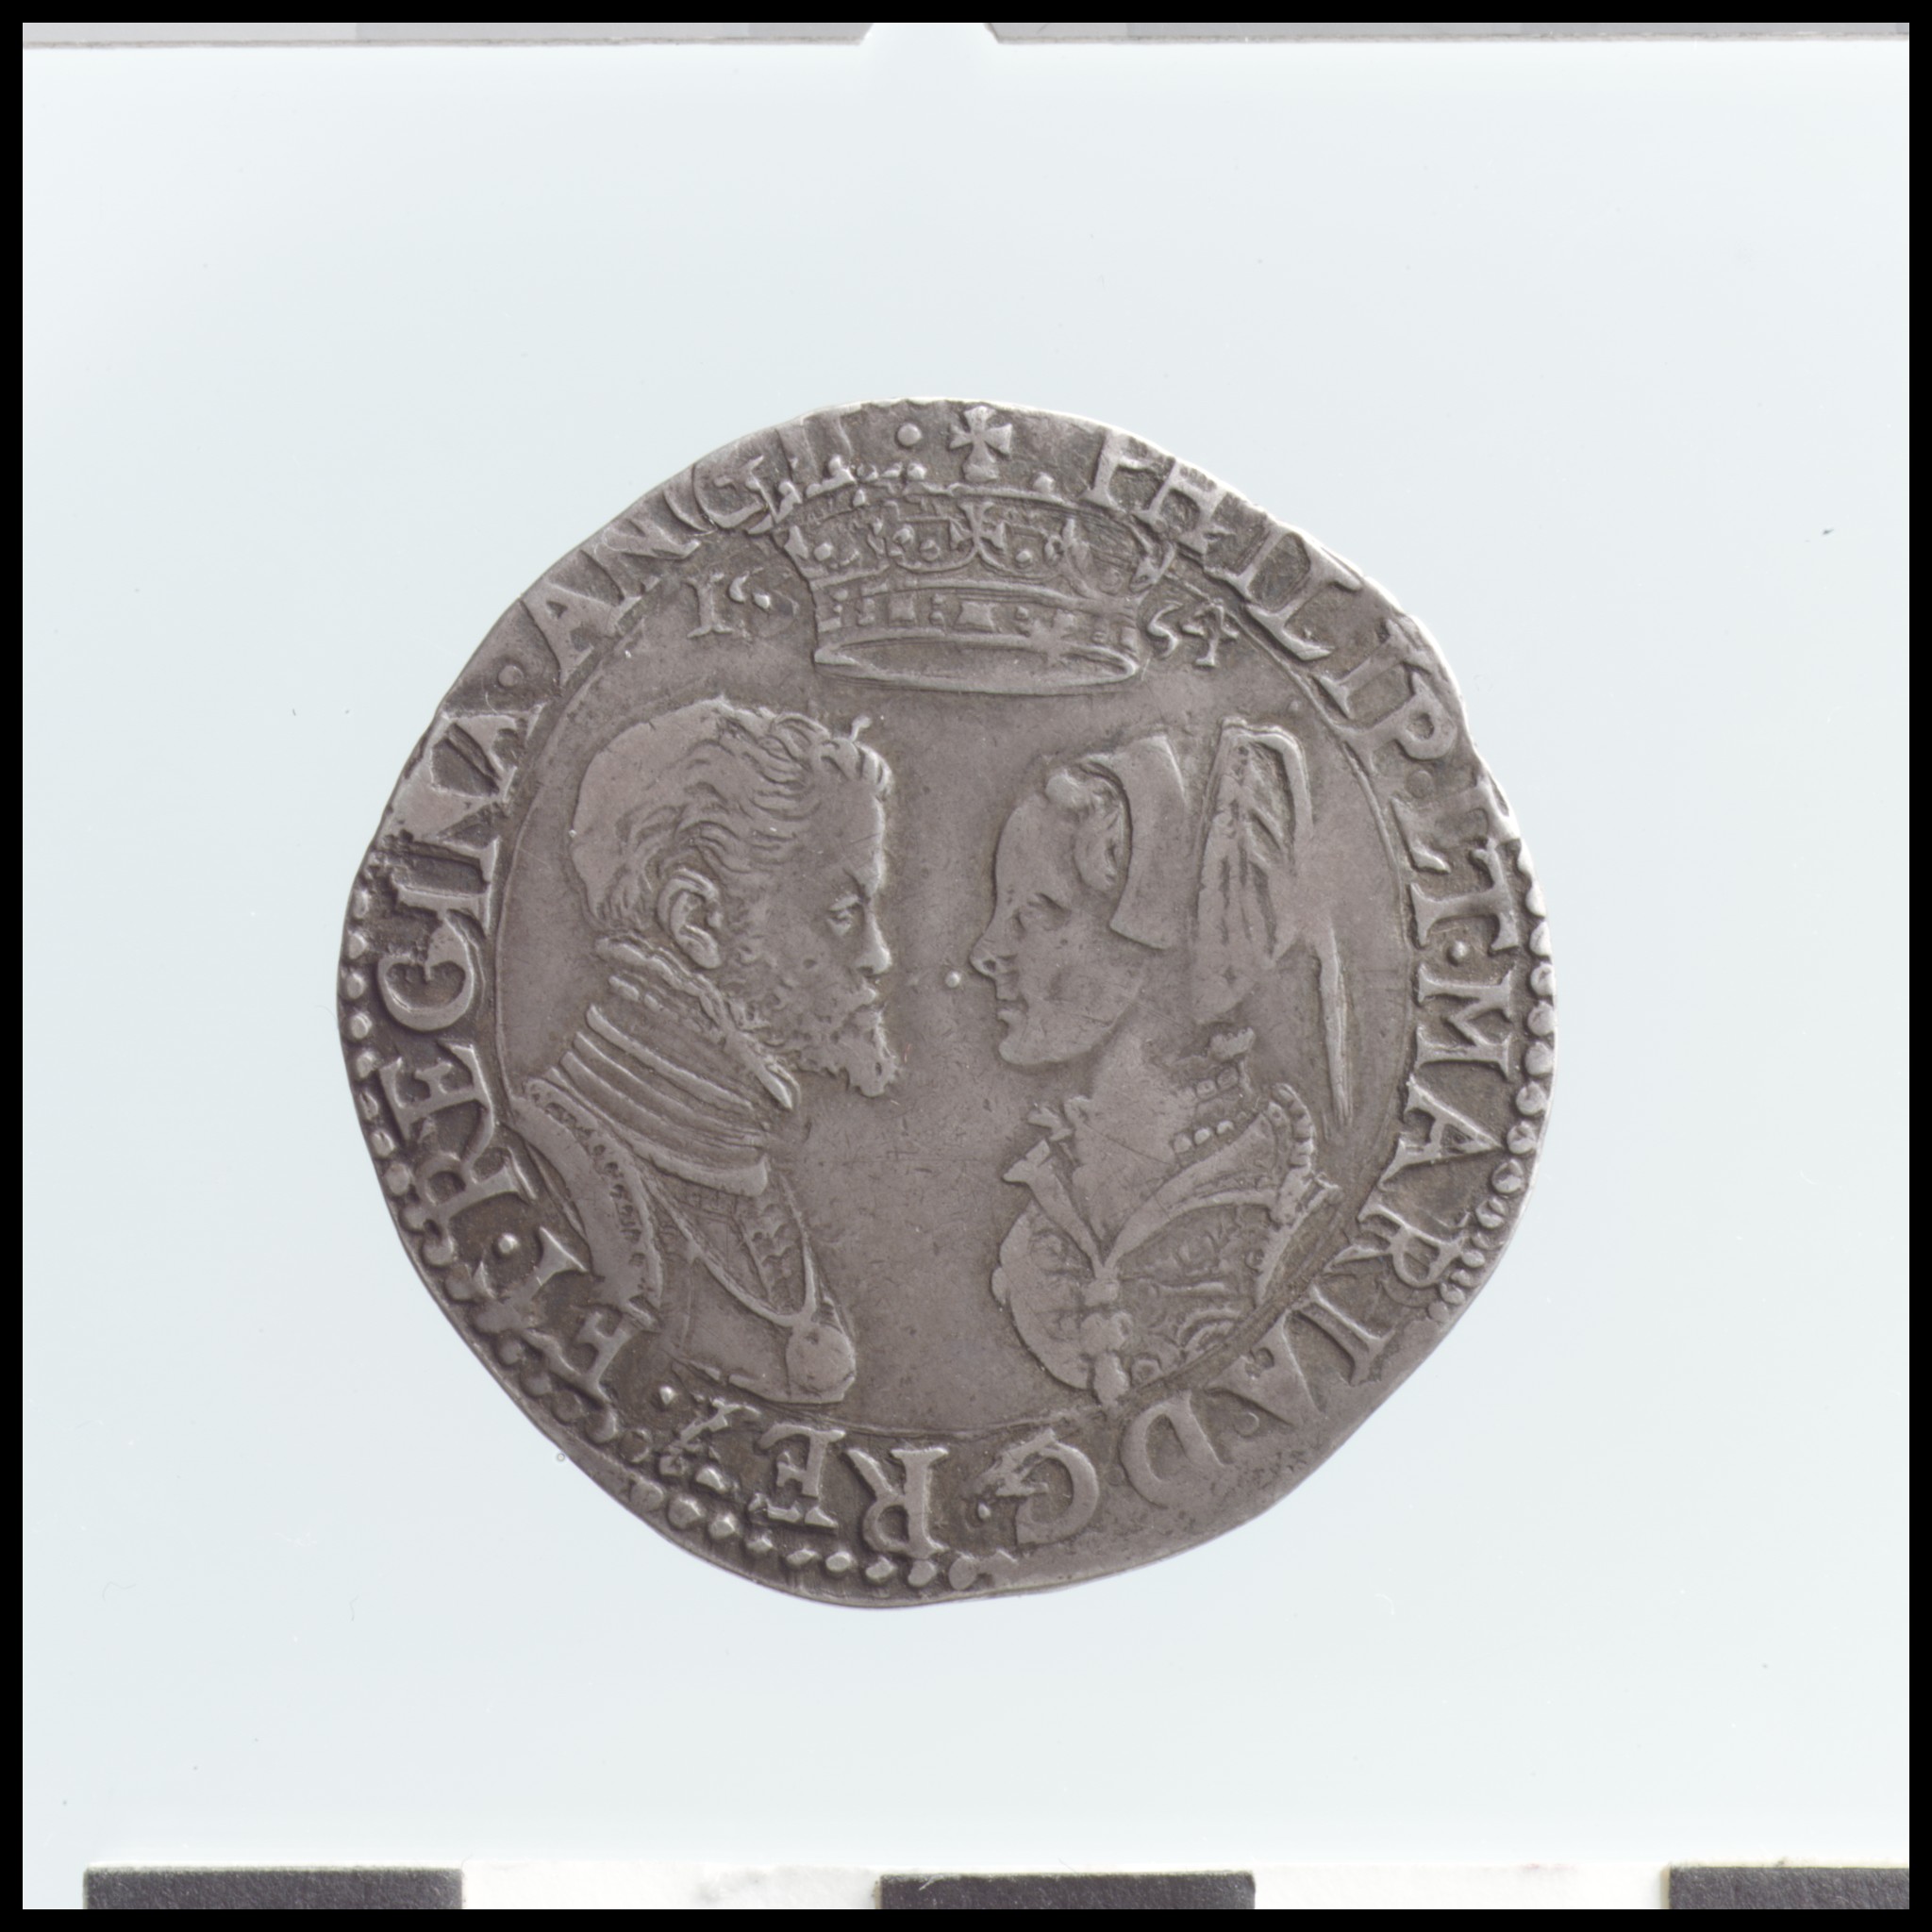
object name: shilling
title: Shilling of Philip and Mary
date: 1554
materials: silver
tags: men,profiles,women,coat of arms